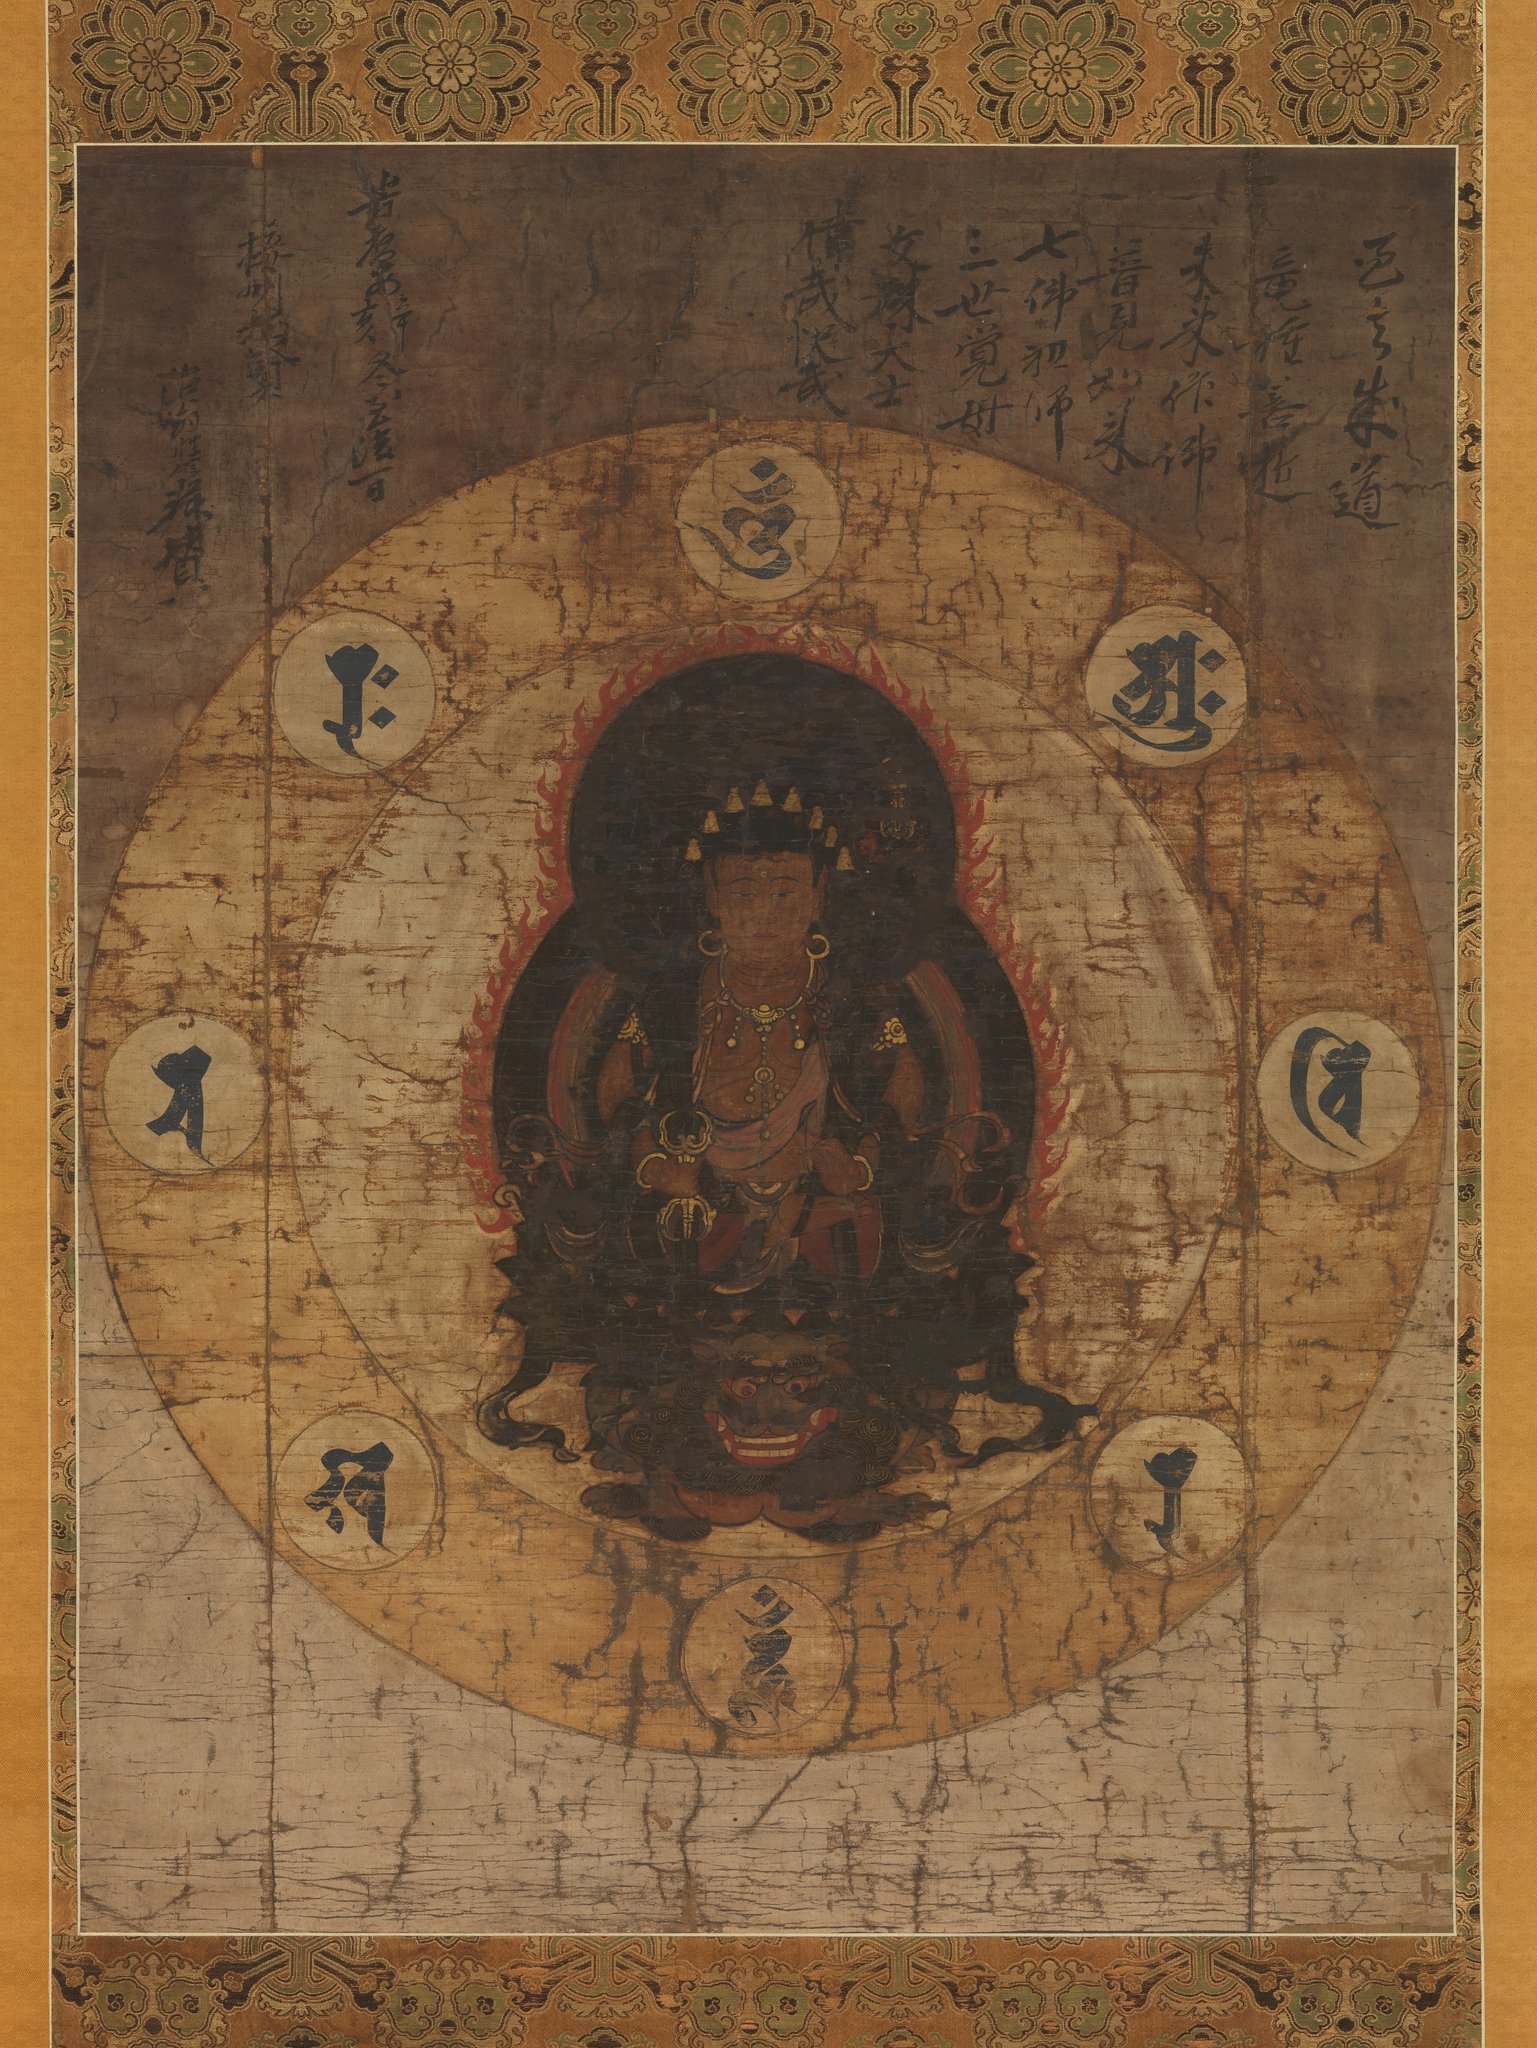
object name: hanging scroll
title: Monju Bosatsu with Eight Sacred Sanskrit Syllables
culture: japanese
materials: ink, silk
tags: lions,buddhism,bodhisattvas